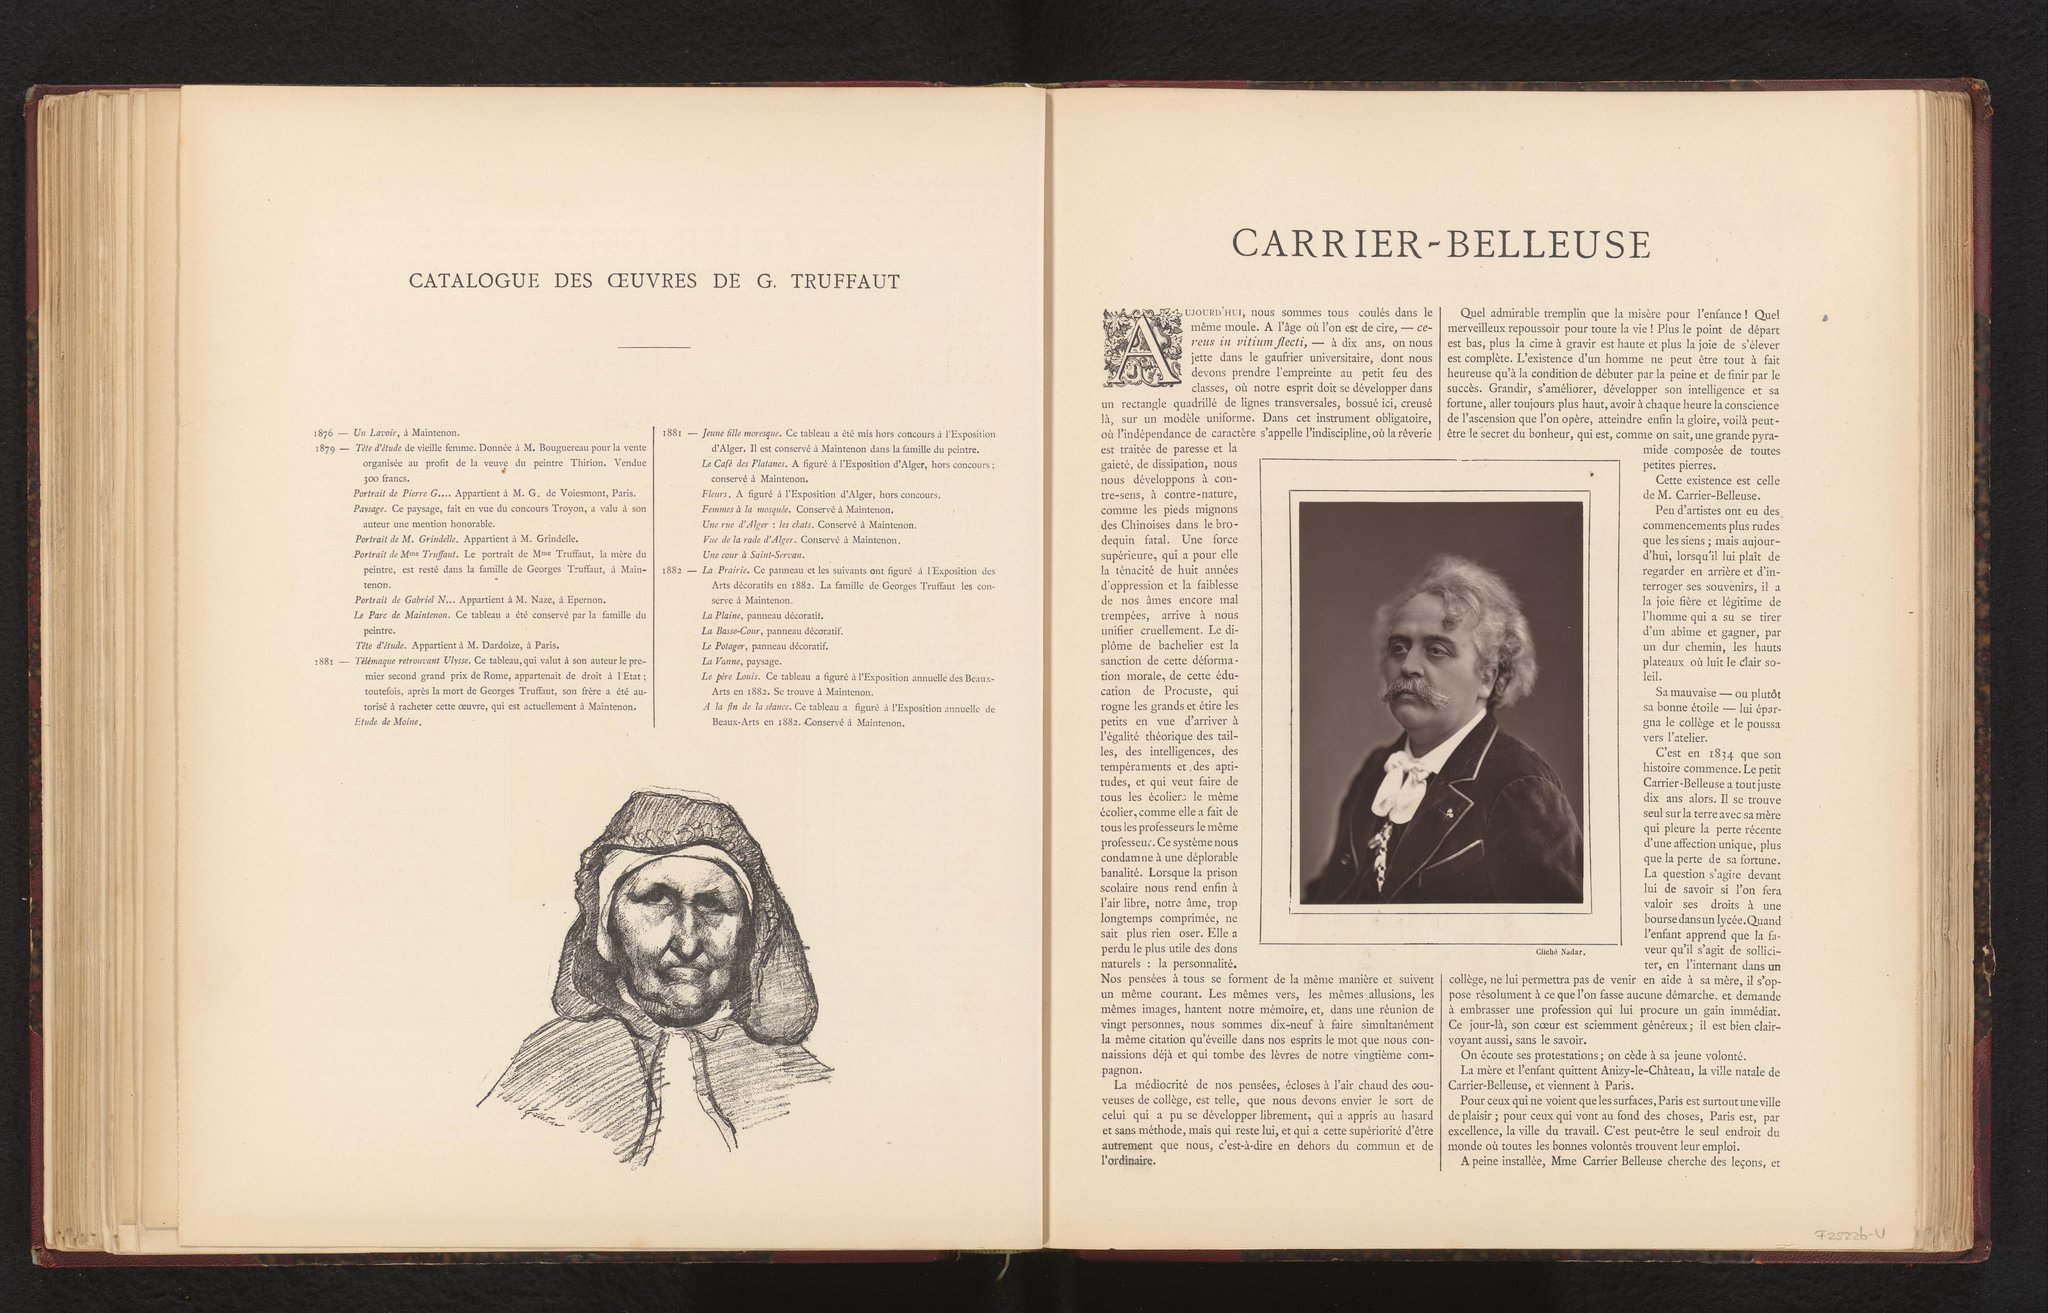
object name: reproduction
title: Reproductie van een portret van Albert-Ernest Carrier-Belleuse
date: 1878-1883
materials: paper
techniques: woodburytype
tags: painter, draughtsman, sculptor, albert-ernest carrier-belleuse, historical persons